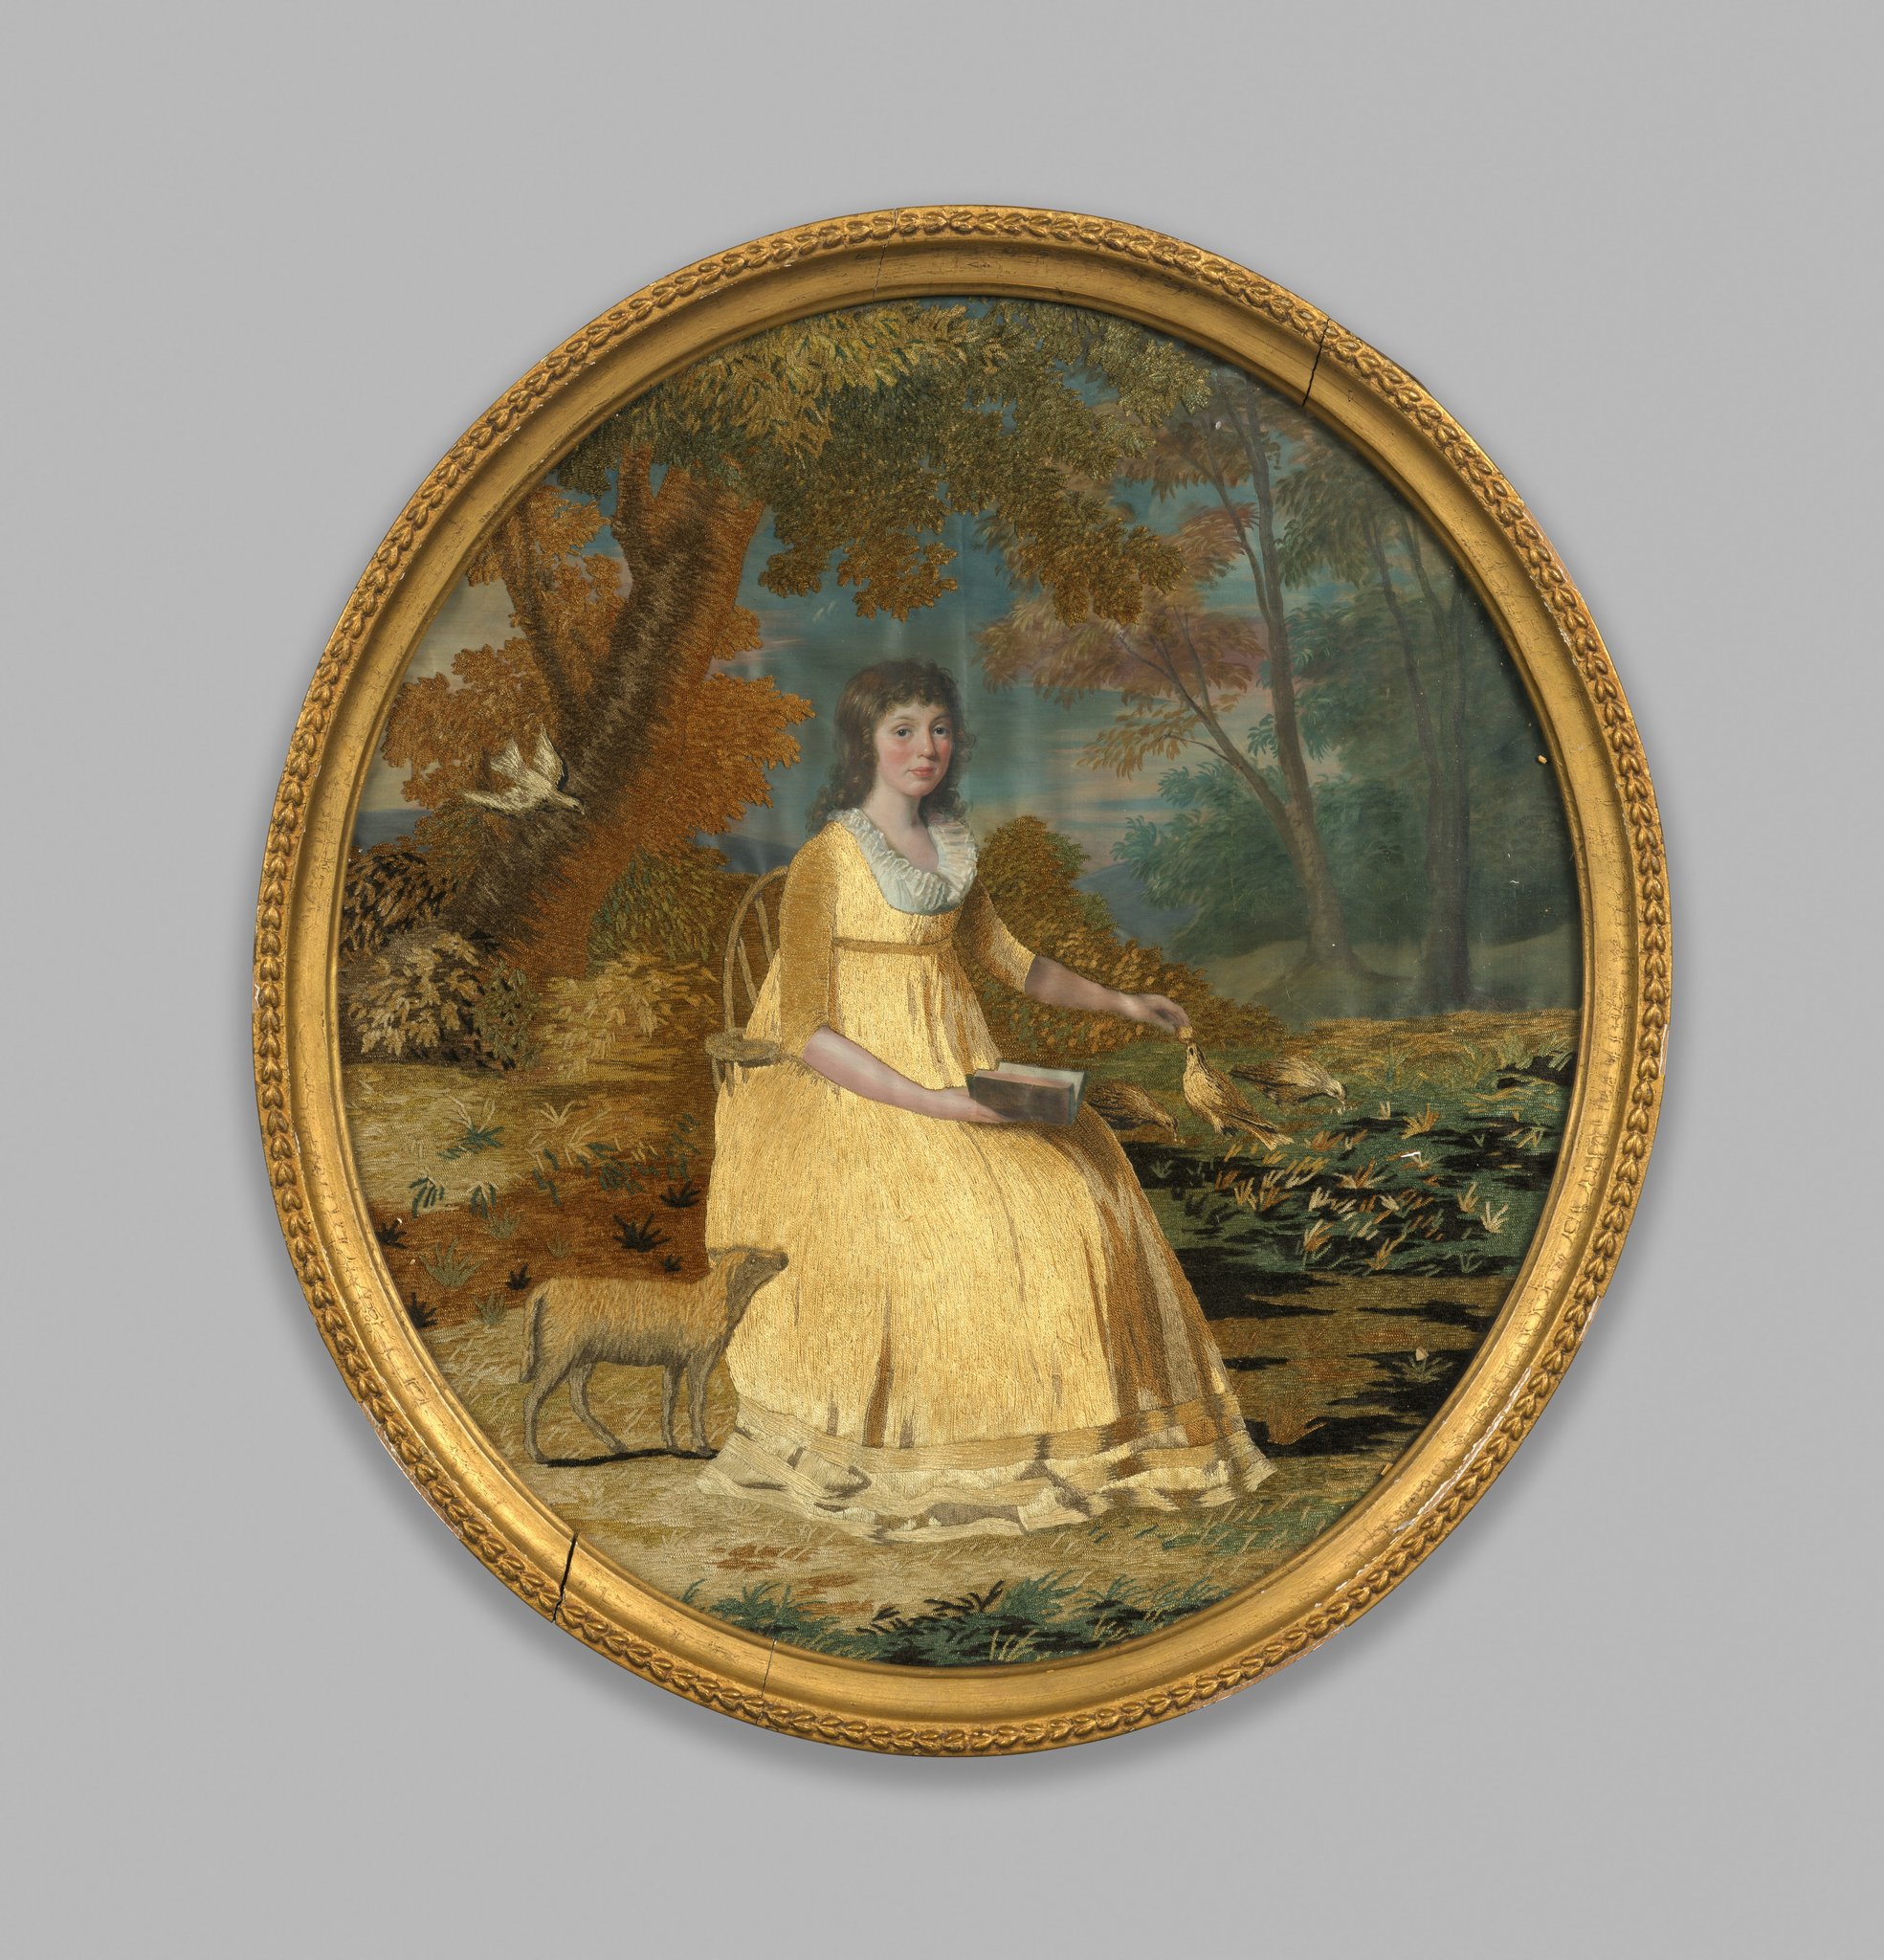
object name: embroidered picture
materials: linen, paint, silk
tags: birds,books,women,lambs